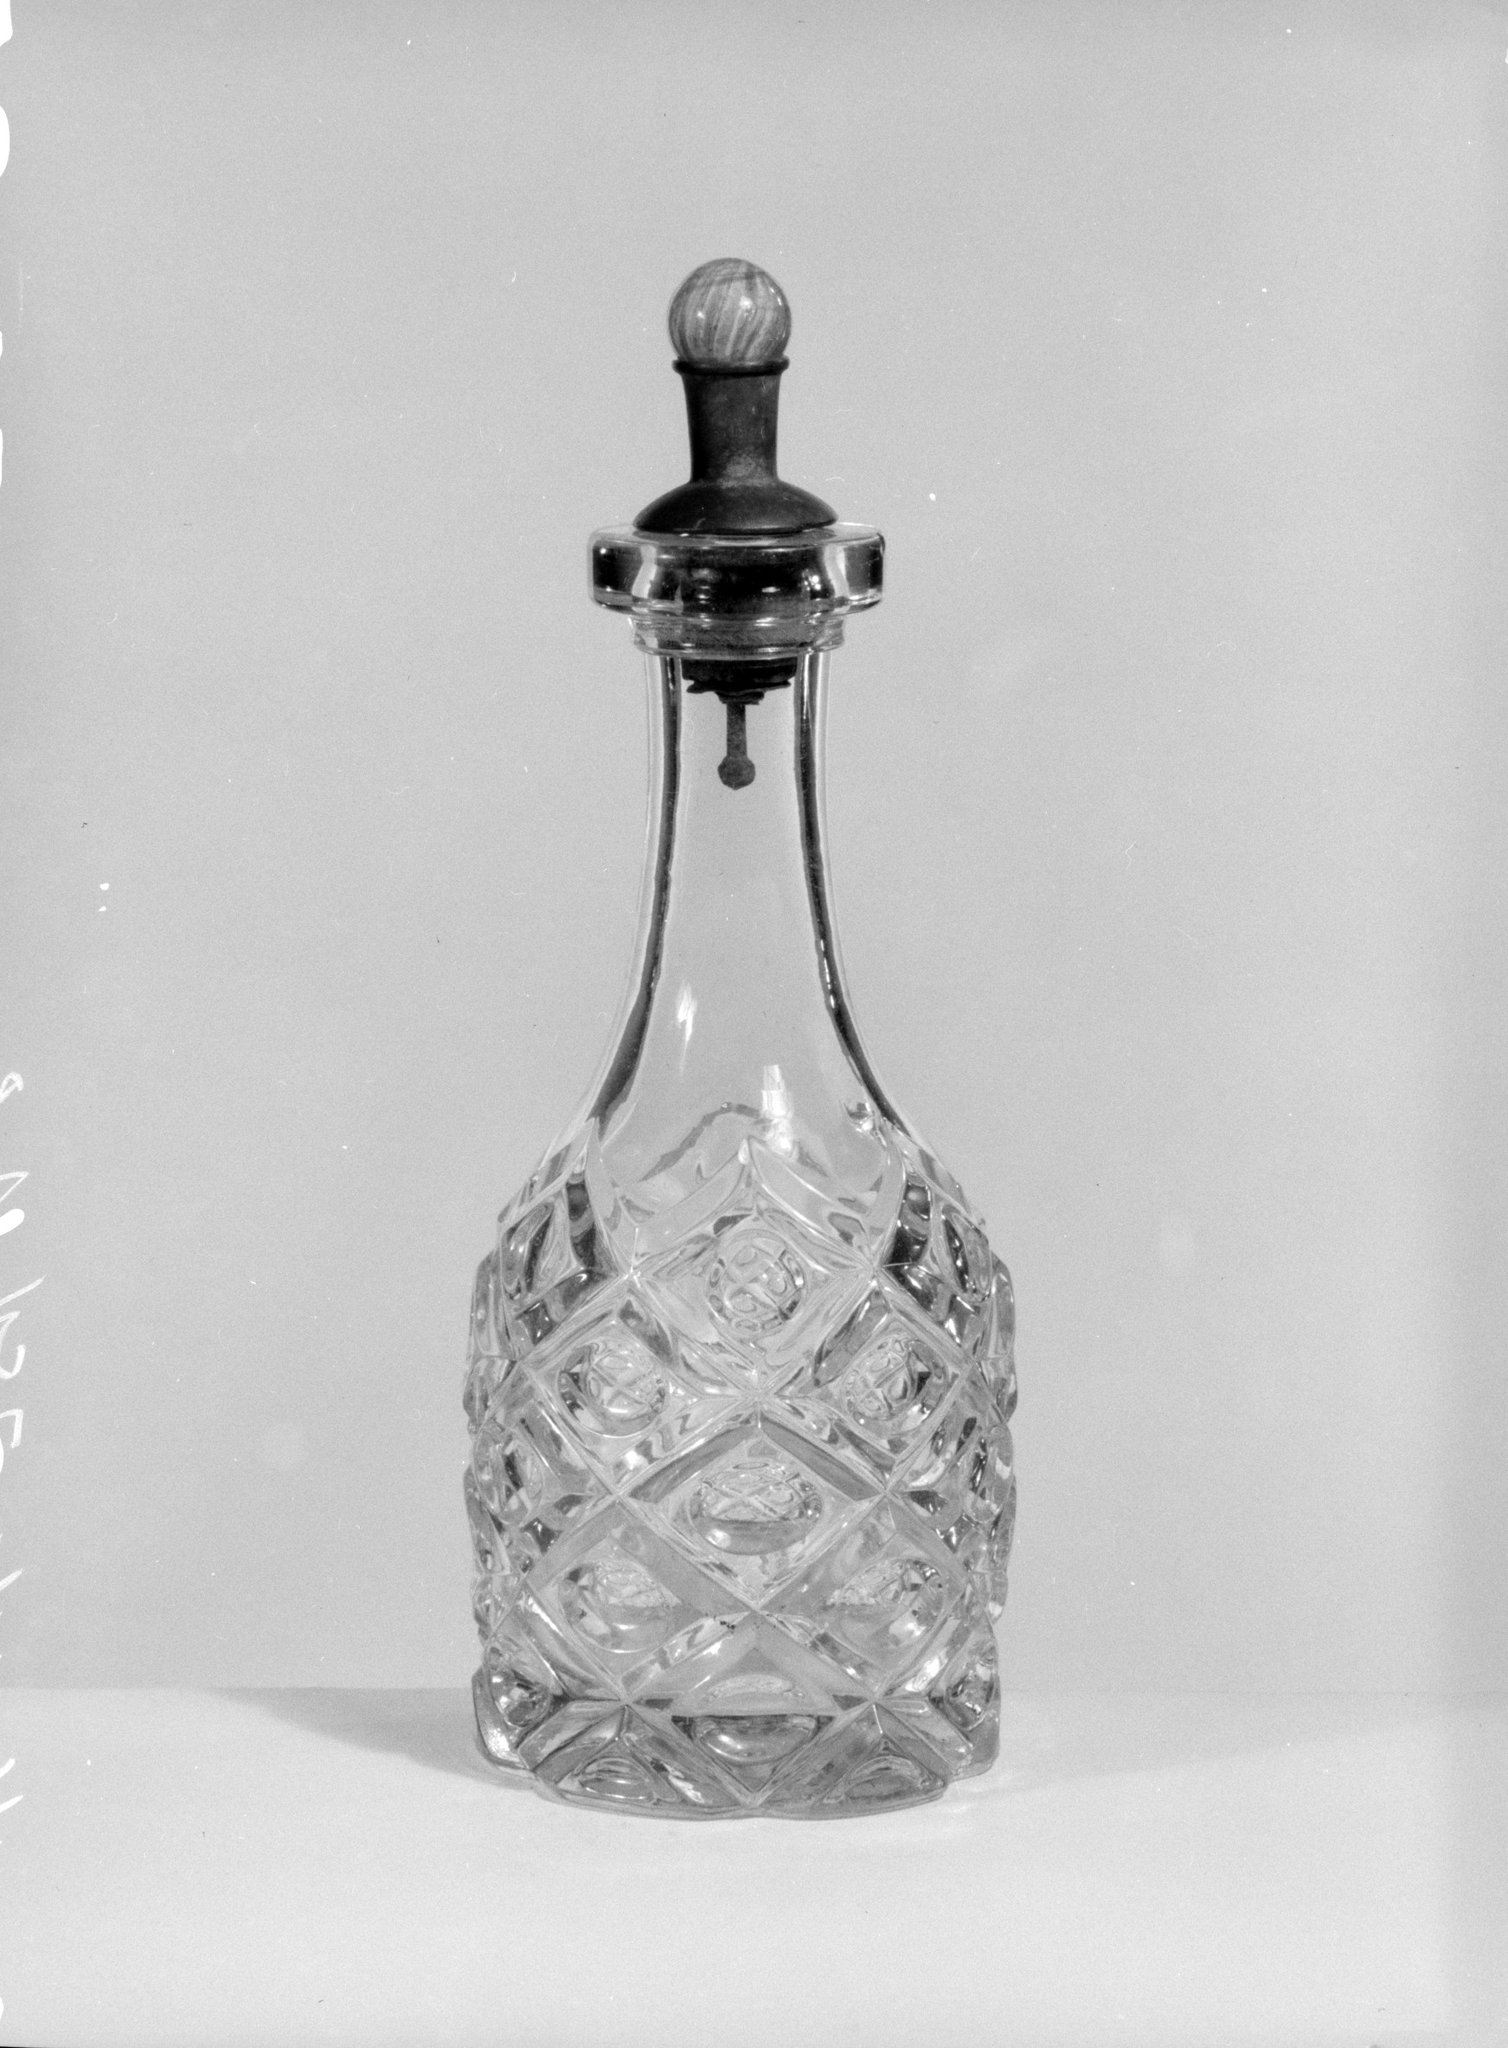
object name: bitter bottle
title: Bitters Bottle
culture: american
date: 1860-1870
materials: diamond, glass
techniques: pressed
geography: united states